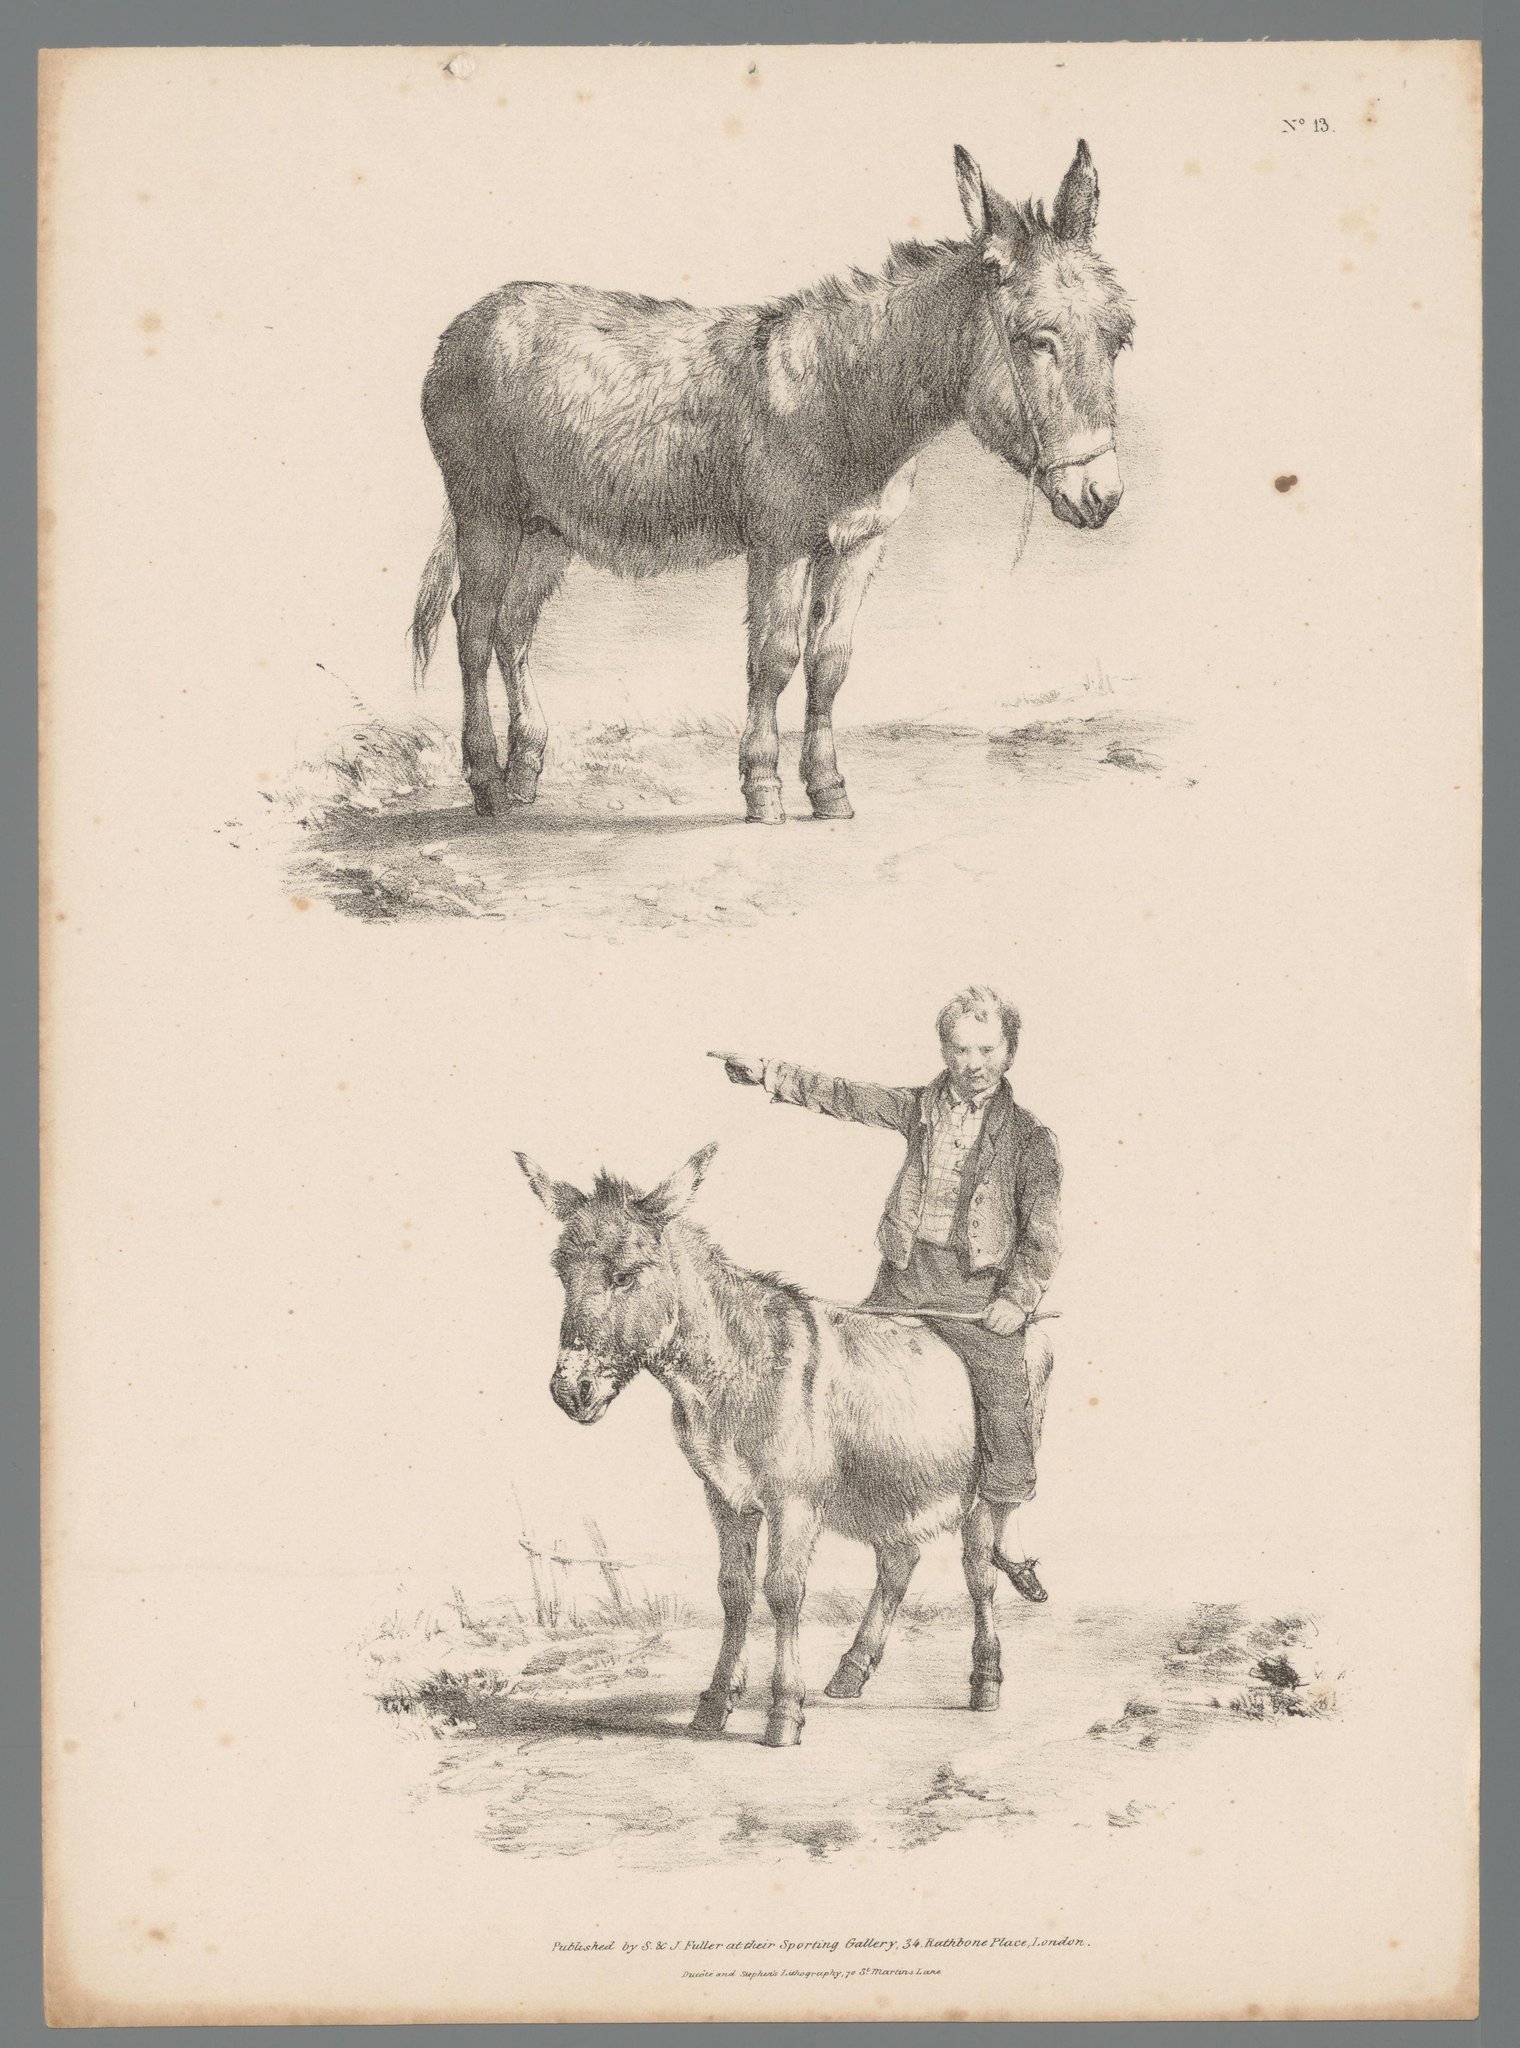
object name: print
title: Studies of cattle, drawn from nature by Thomas Sidney Cooper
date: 1837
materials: paper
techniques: lithograph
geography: london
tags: riding a horse, ass, or mule; rider, horseman, ass, donkey, cattle, index finger forwards, pointing, indicating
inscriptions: collector's mark: Lugt 2228